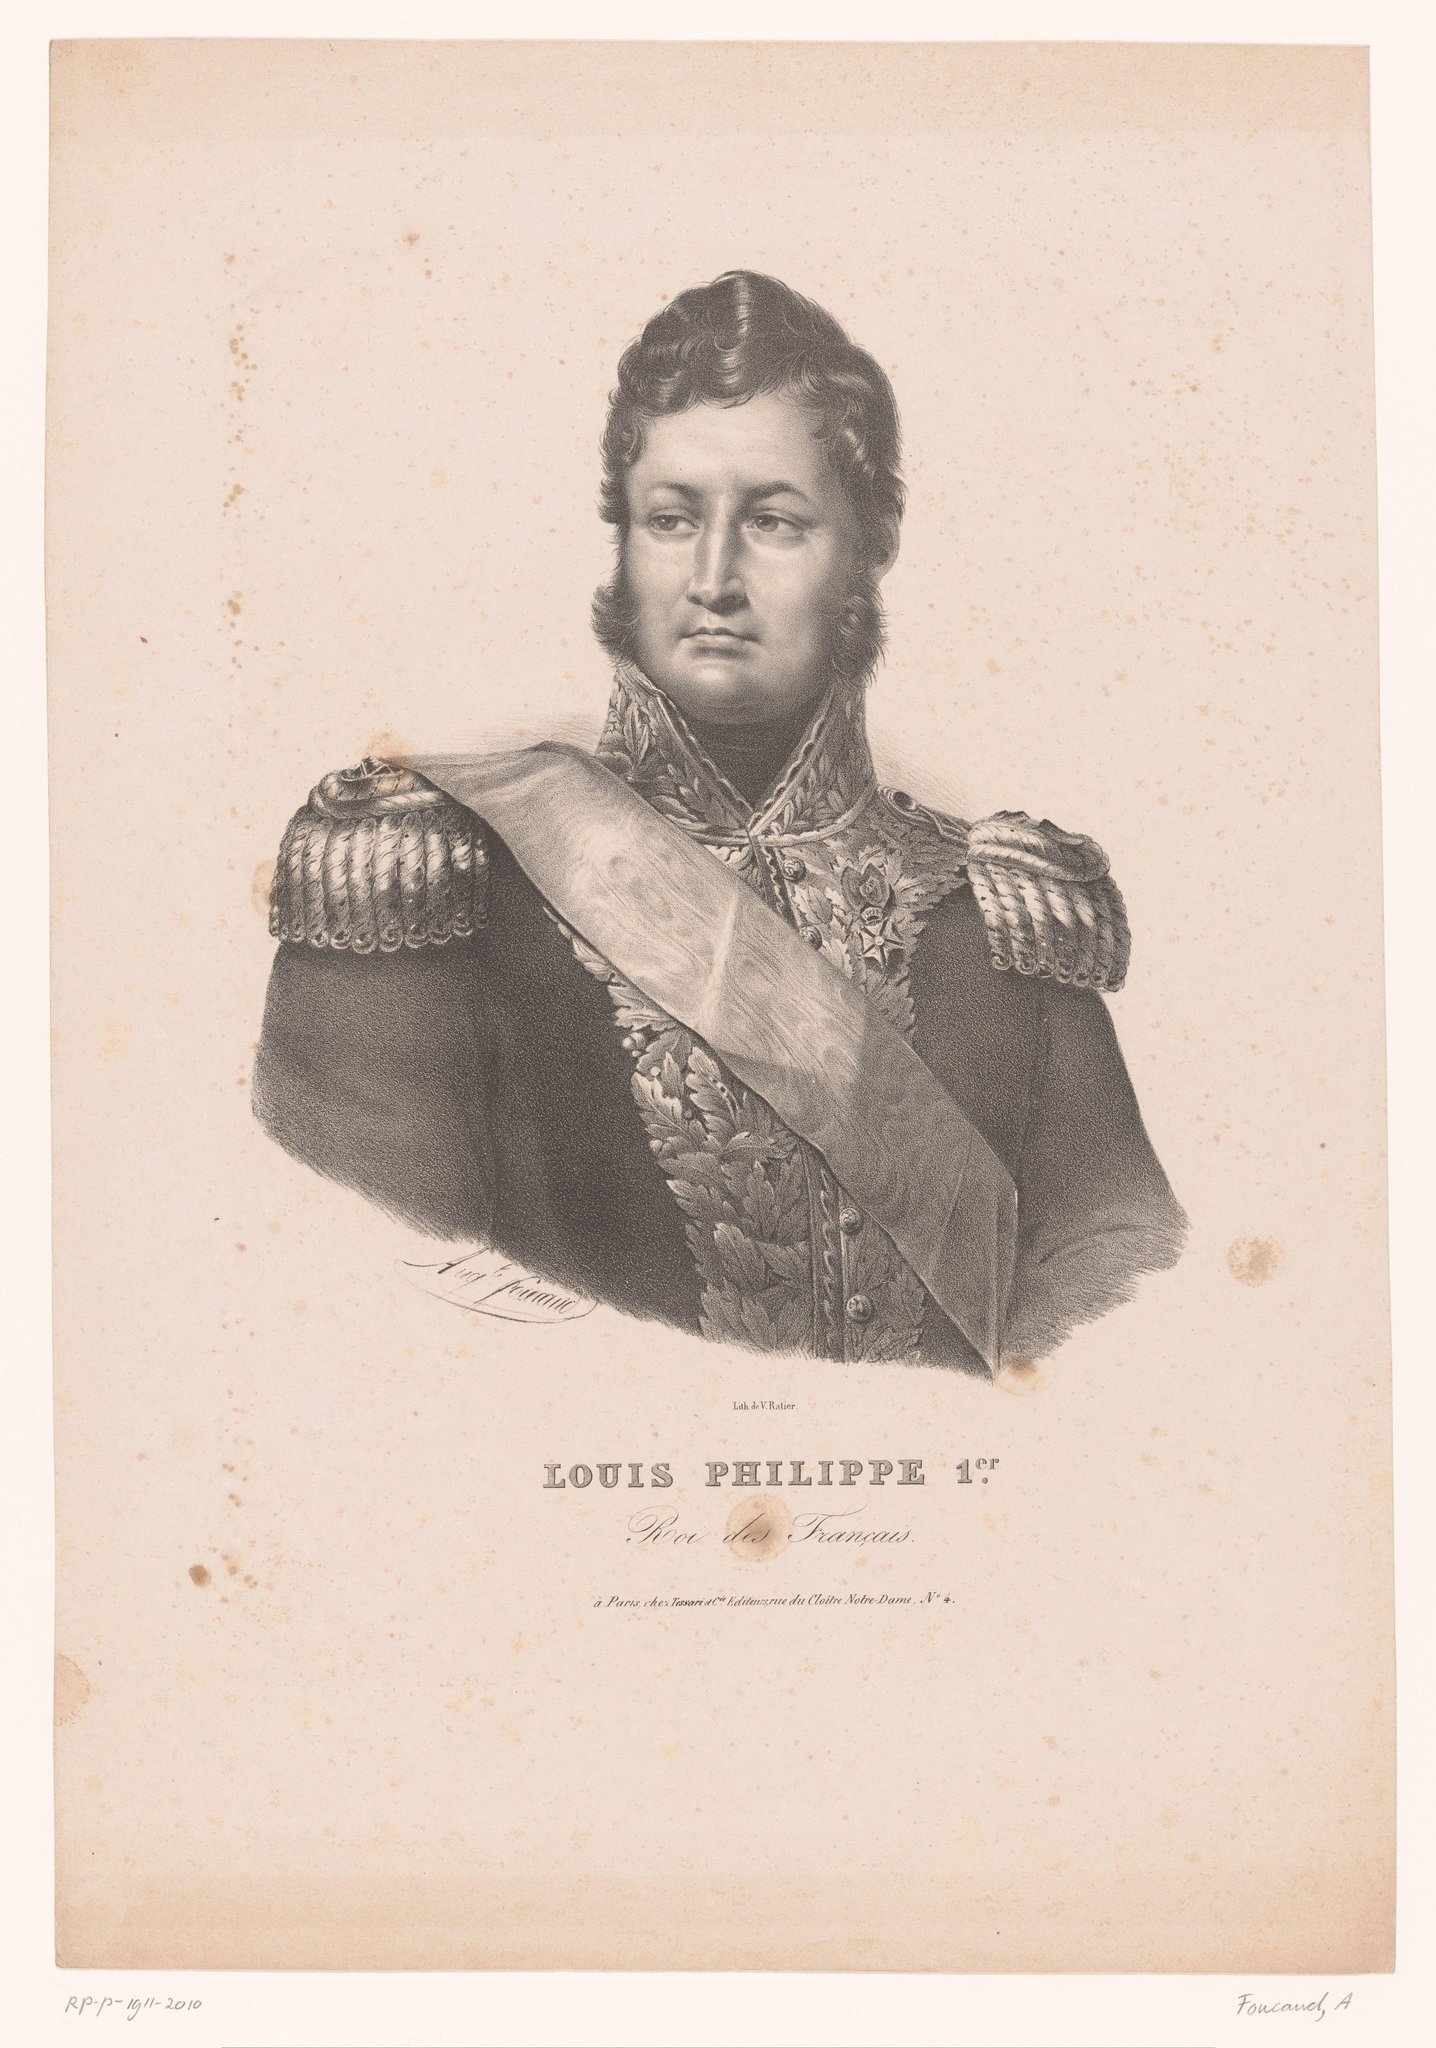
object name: print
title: Portret van Lodewijk Filips I van Frankrijk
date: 1830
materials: paper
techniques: lithograph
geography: paris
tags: paris, lodewijk filips i (koning van frankrijk), historical persons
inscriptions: collector's mark: Lugt 2228a